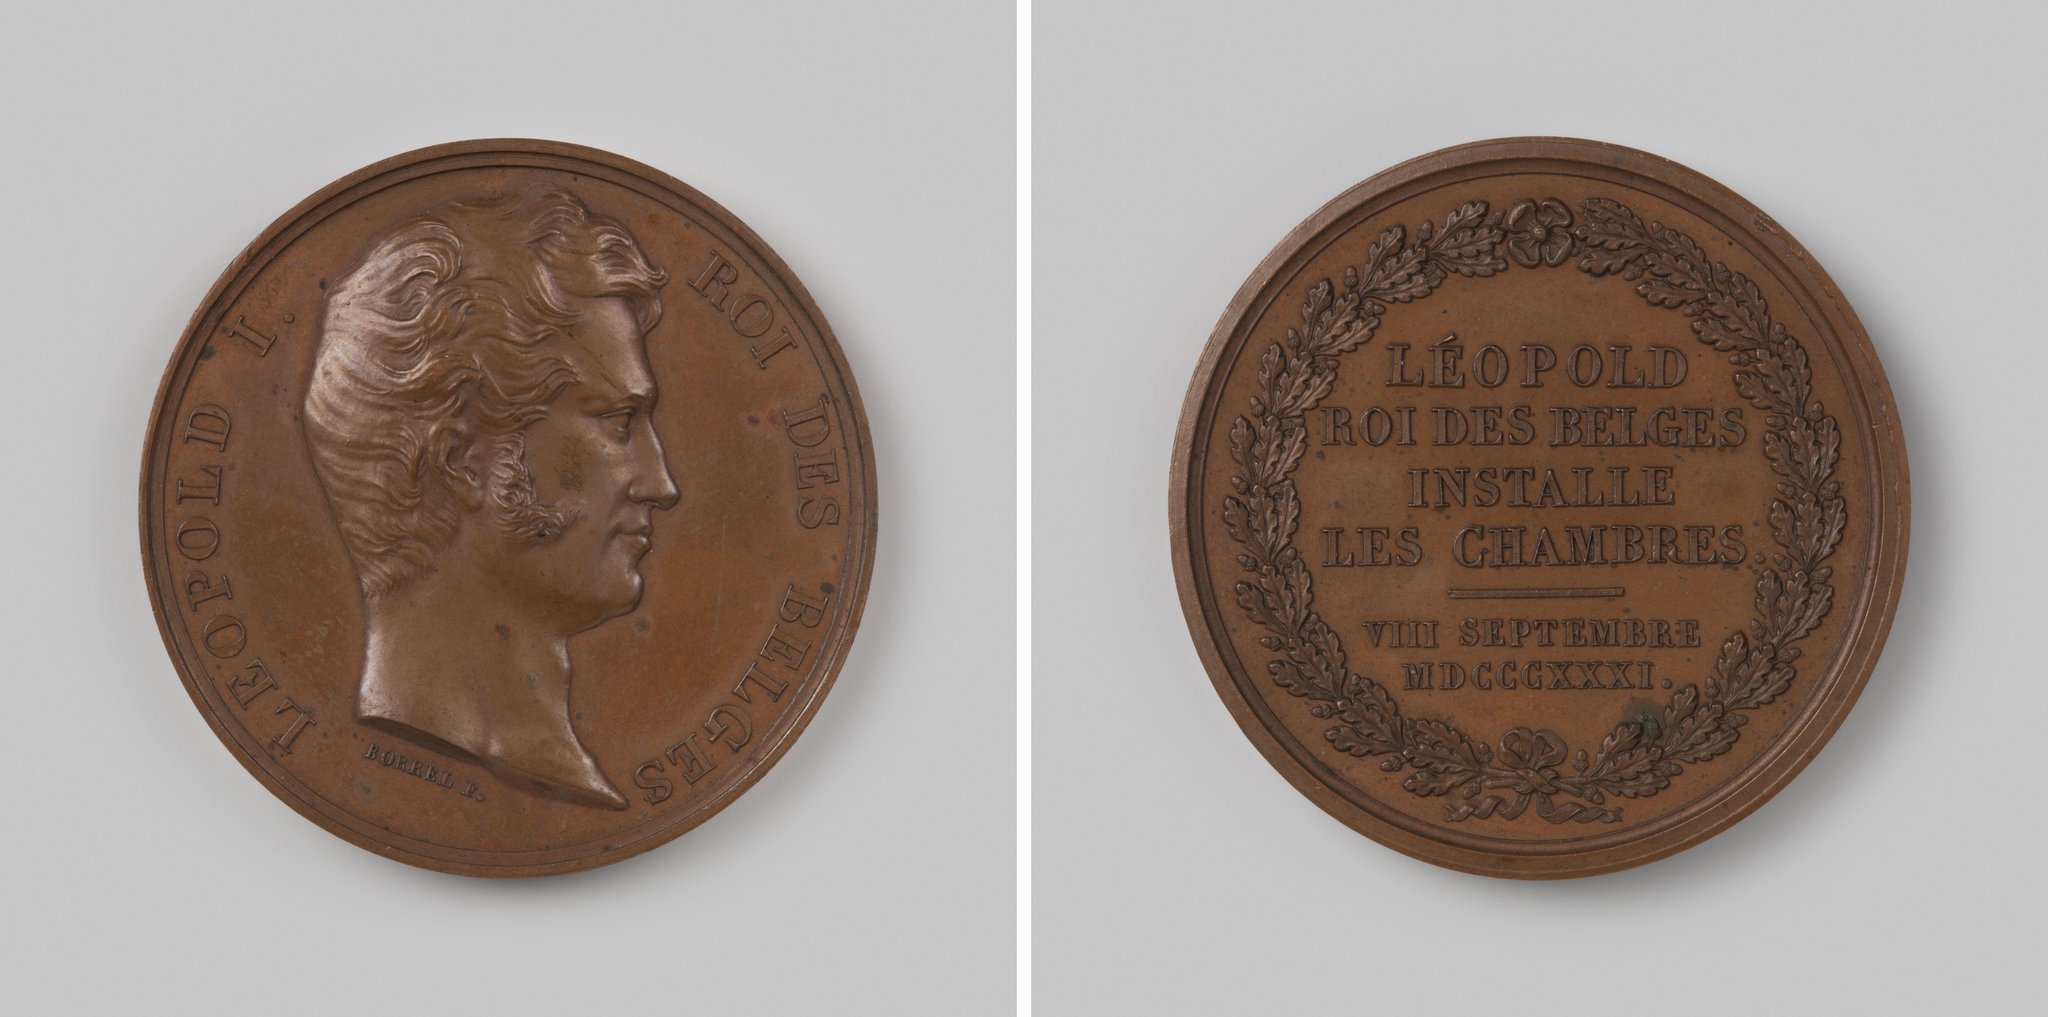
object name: history medal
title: Eerste zitting van de volksvertegenwoordiging, ter ere van Leopold I, koning der Belgen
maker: m. borrel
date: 1831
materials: bronze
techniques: striking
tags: leopold i (koning der belgen), brussels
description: Bronzen penning. Voorzijde: borststuk man binnen omschrift. Keerzijde: opschrift binnen eikenkrans